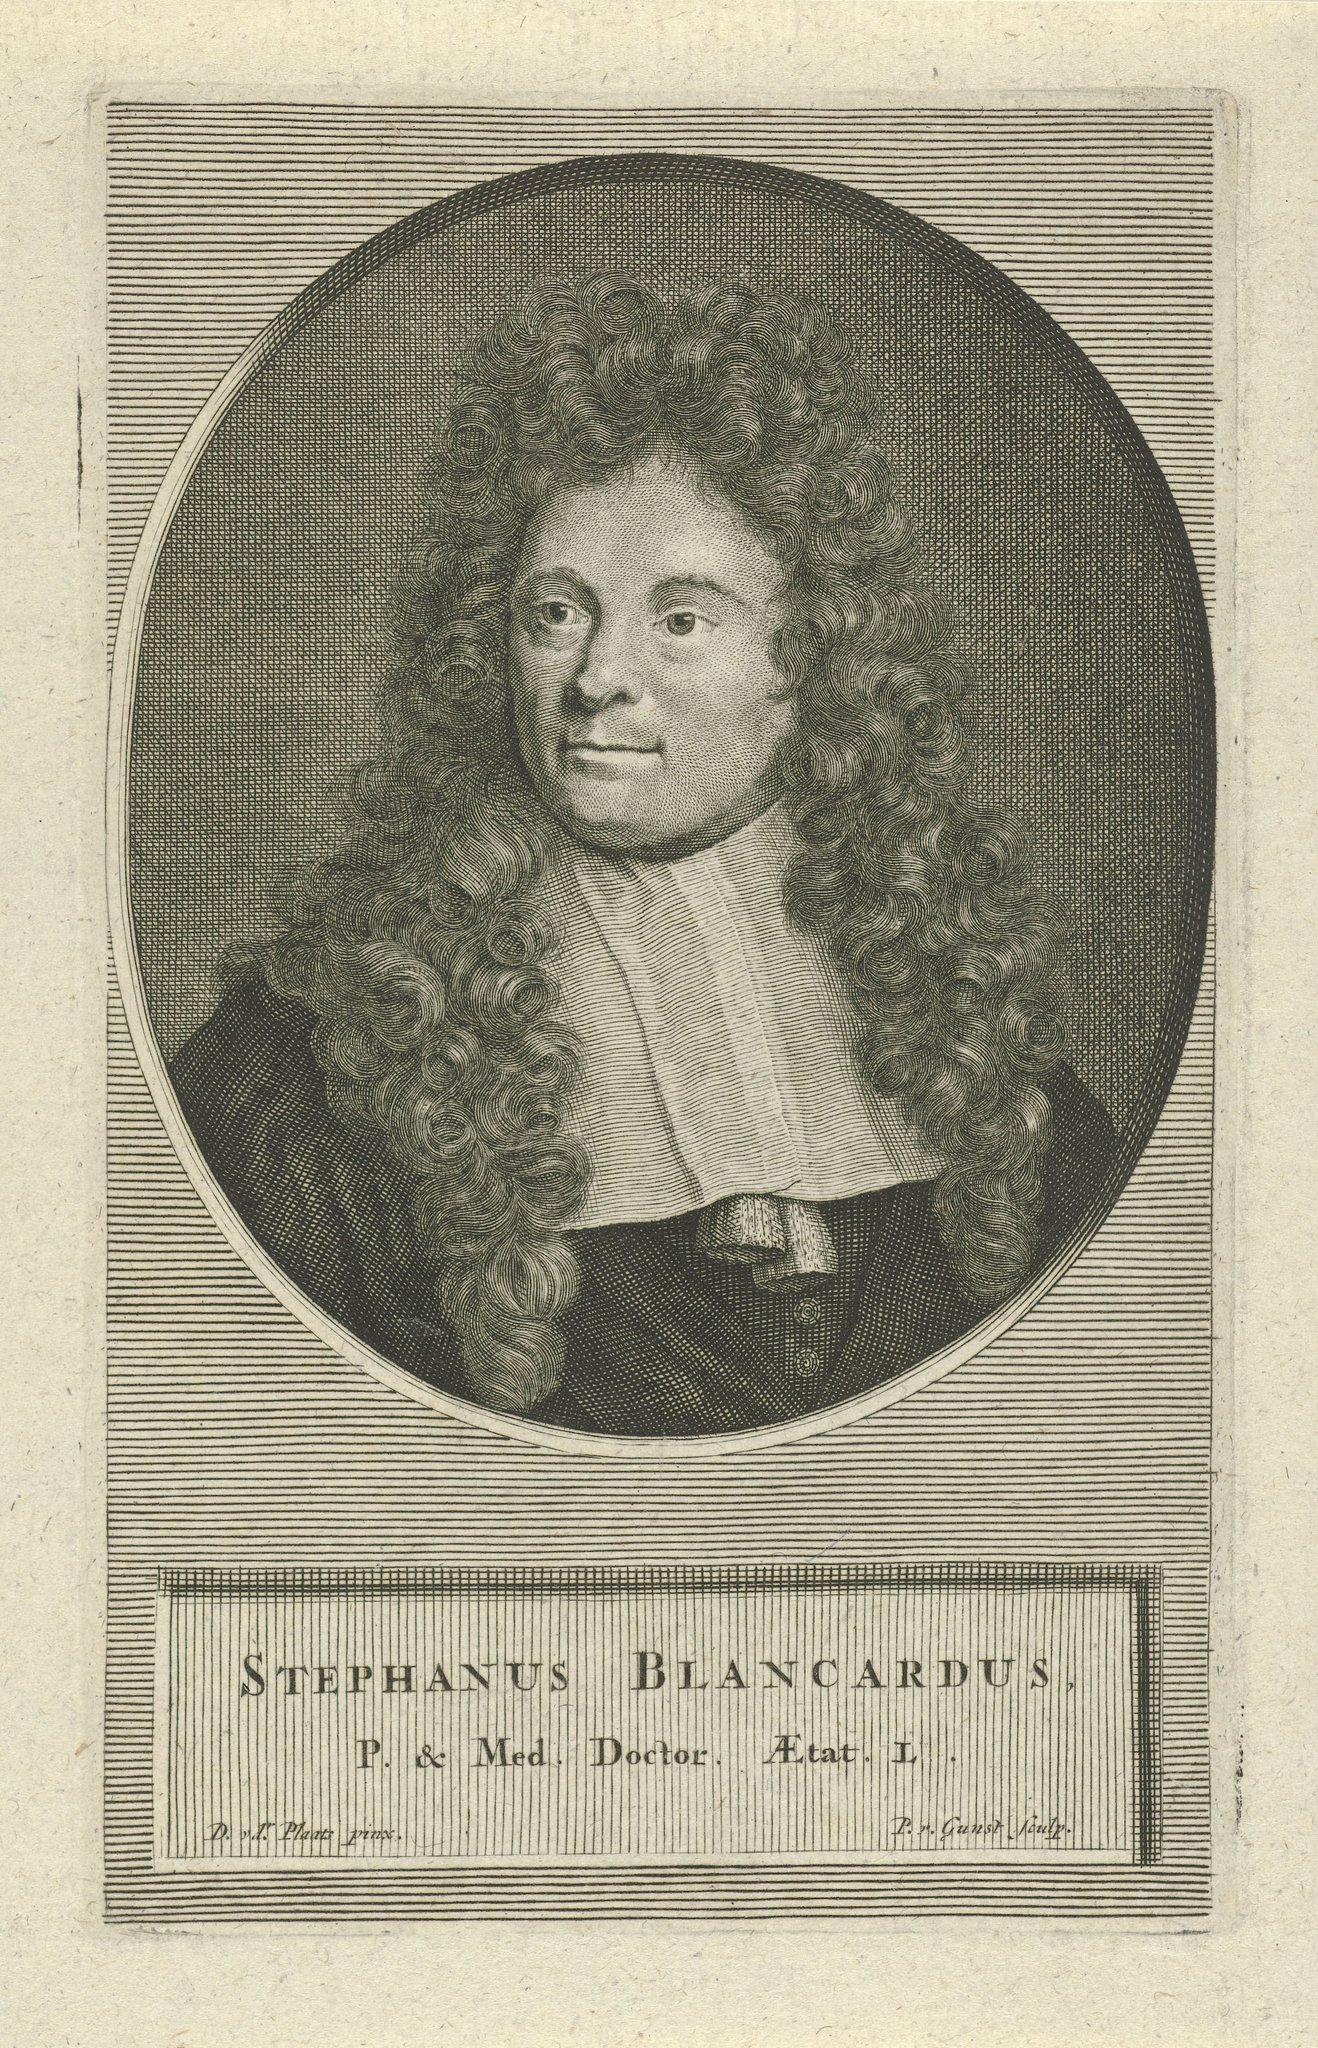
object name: print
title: Portret van Steven Blankaart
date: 1700-1731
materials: paper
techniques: engraving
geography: amsterdam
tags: middelburg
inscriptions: collector's mark: Lugt 2228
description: Steven Blankaart, Nederlands dichter en geneesheer te Amsterdam, op vijftigjarige leeftijd.